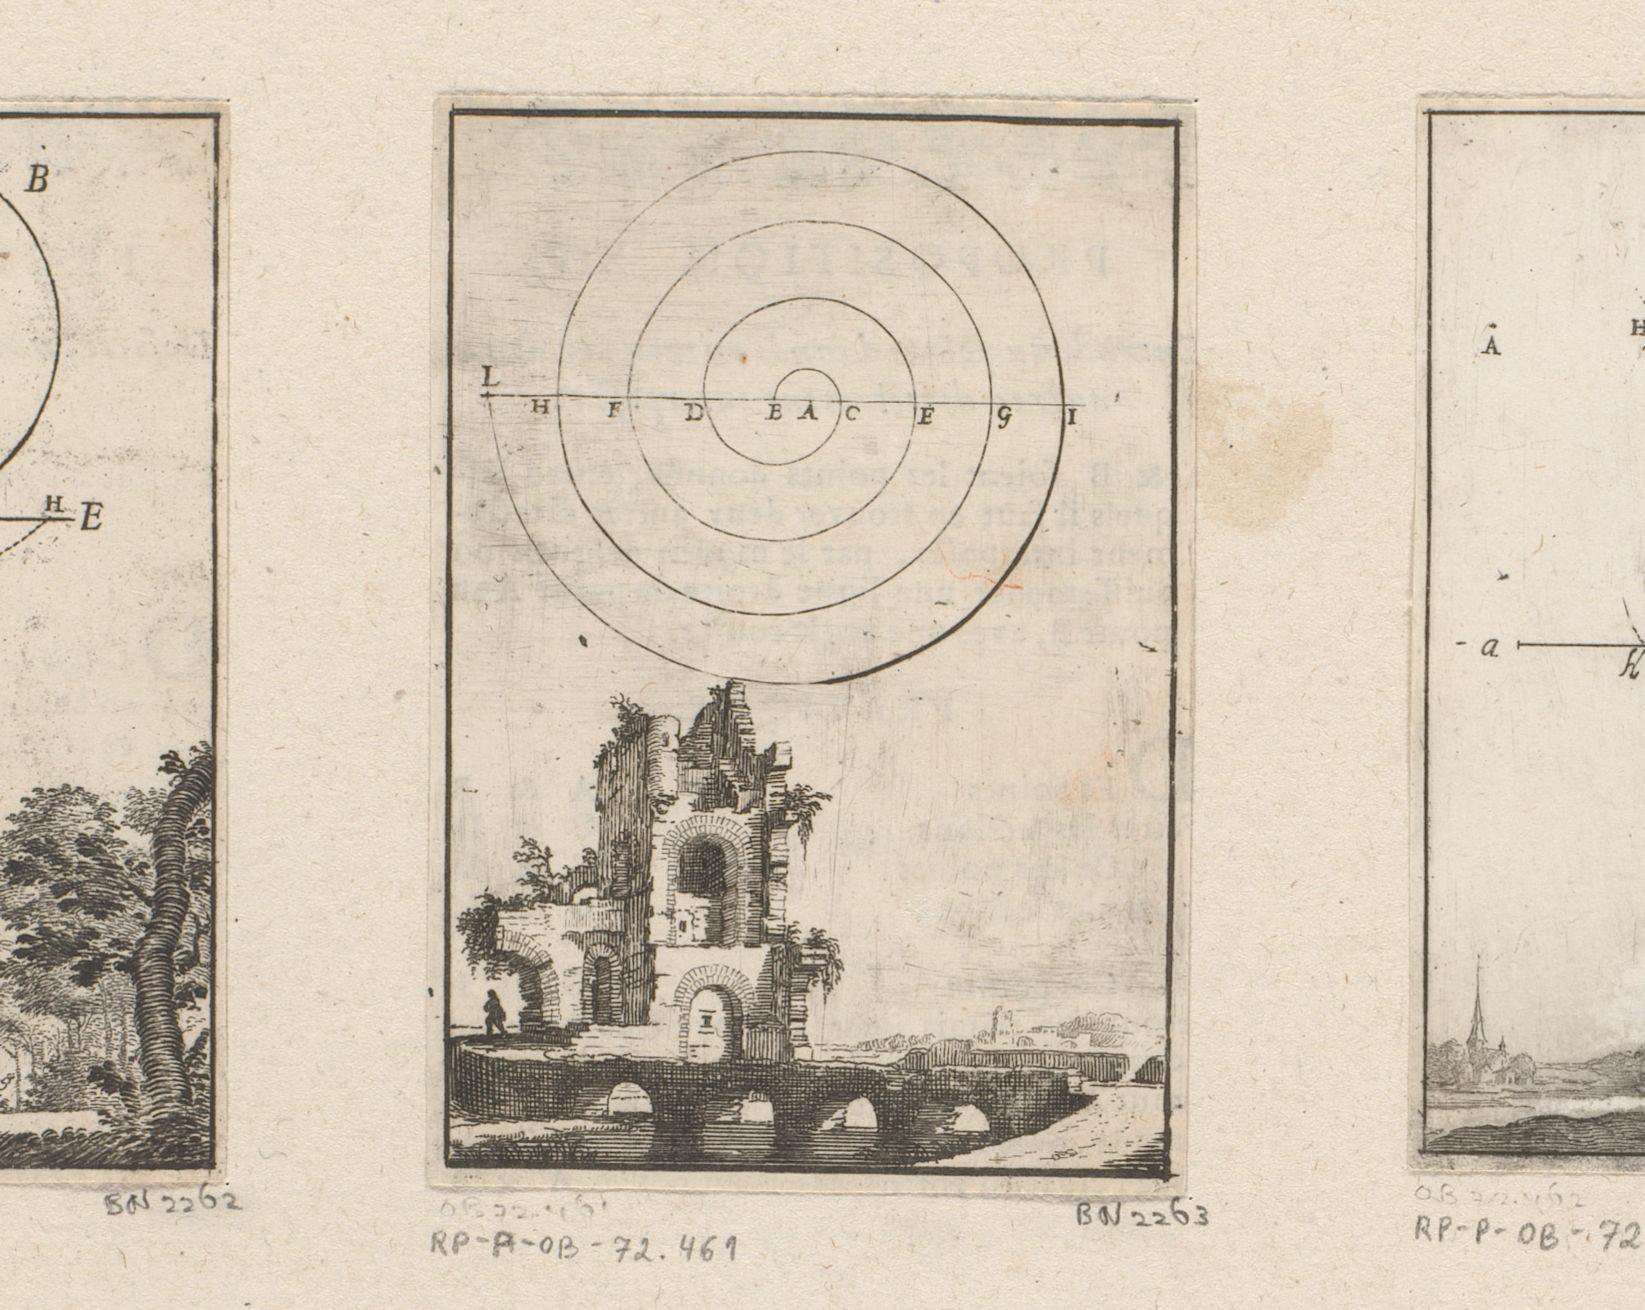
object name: book illustration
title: Spiraal met onderaan een ruïne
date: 1669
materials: paper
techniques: etching, letterpress printing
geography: paris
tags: spiral (~ planimetry, geometry), landscape with ruins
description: Prent uit: Pratique de la géometrie, sur le papier et sur le terrain. Avec un nouvel ordre et une méthode particulière. Parijs: Thomas Jolly, 1669.